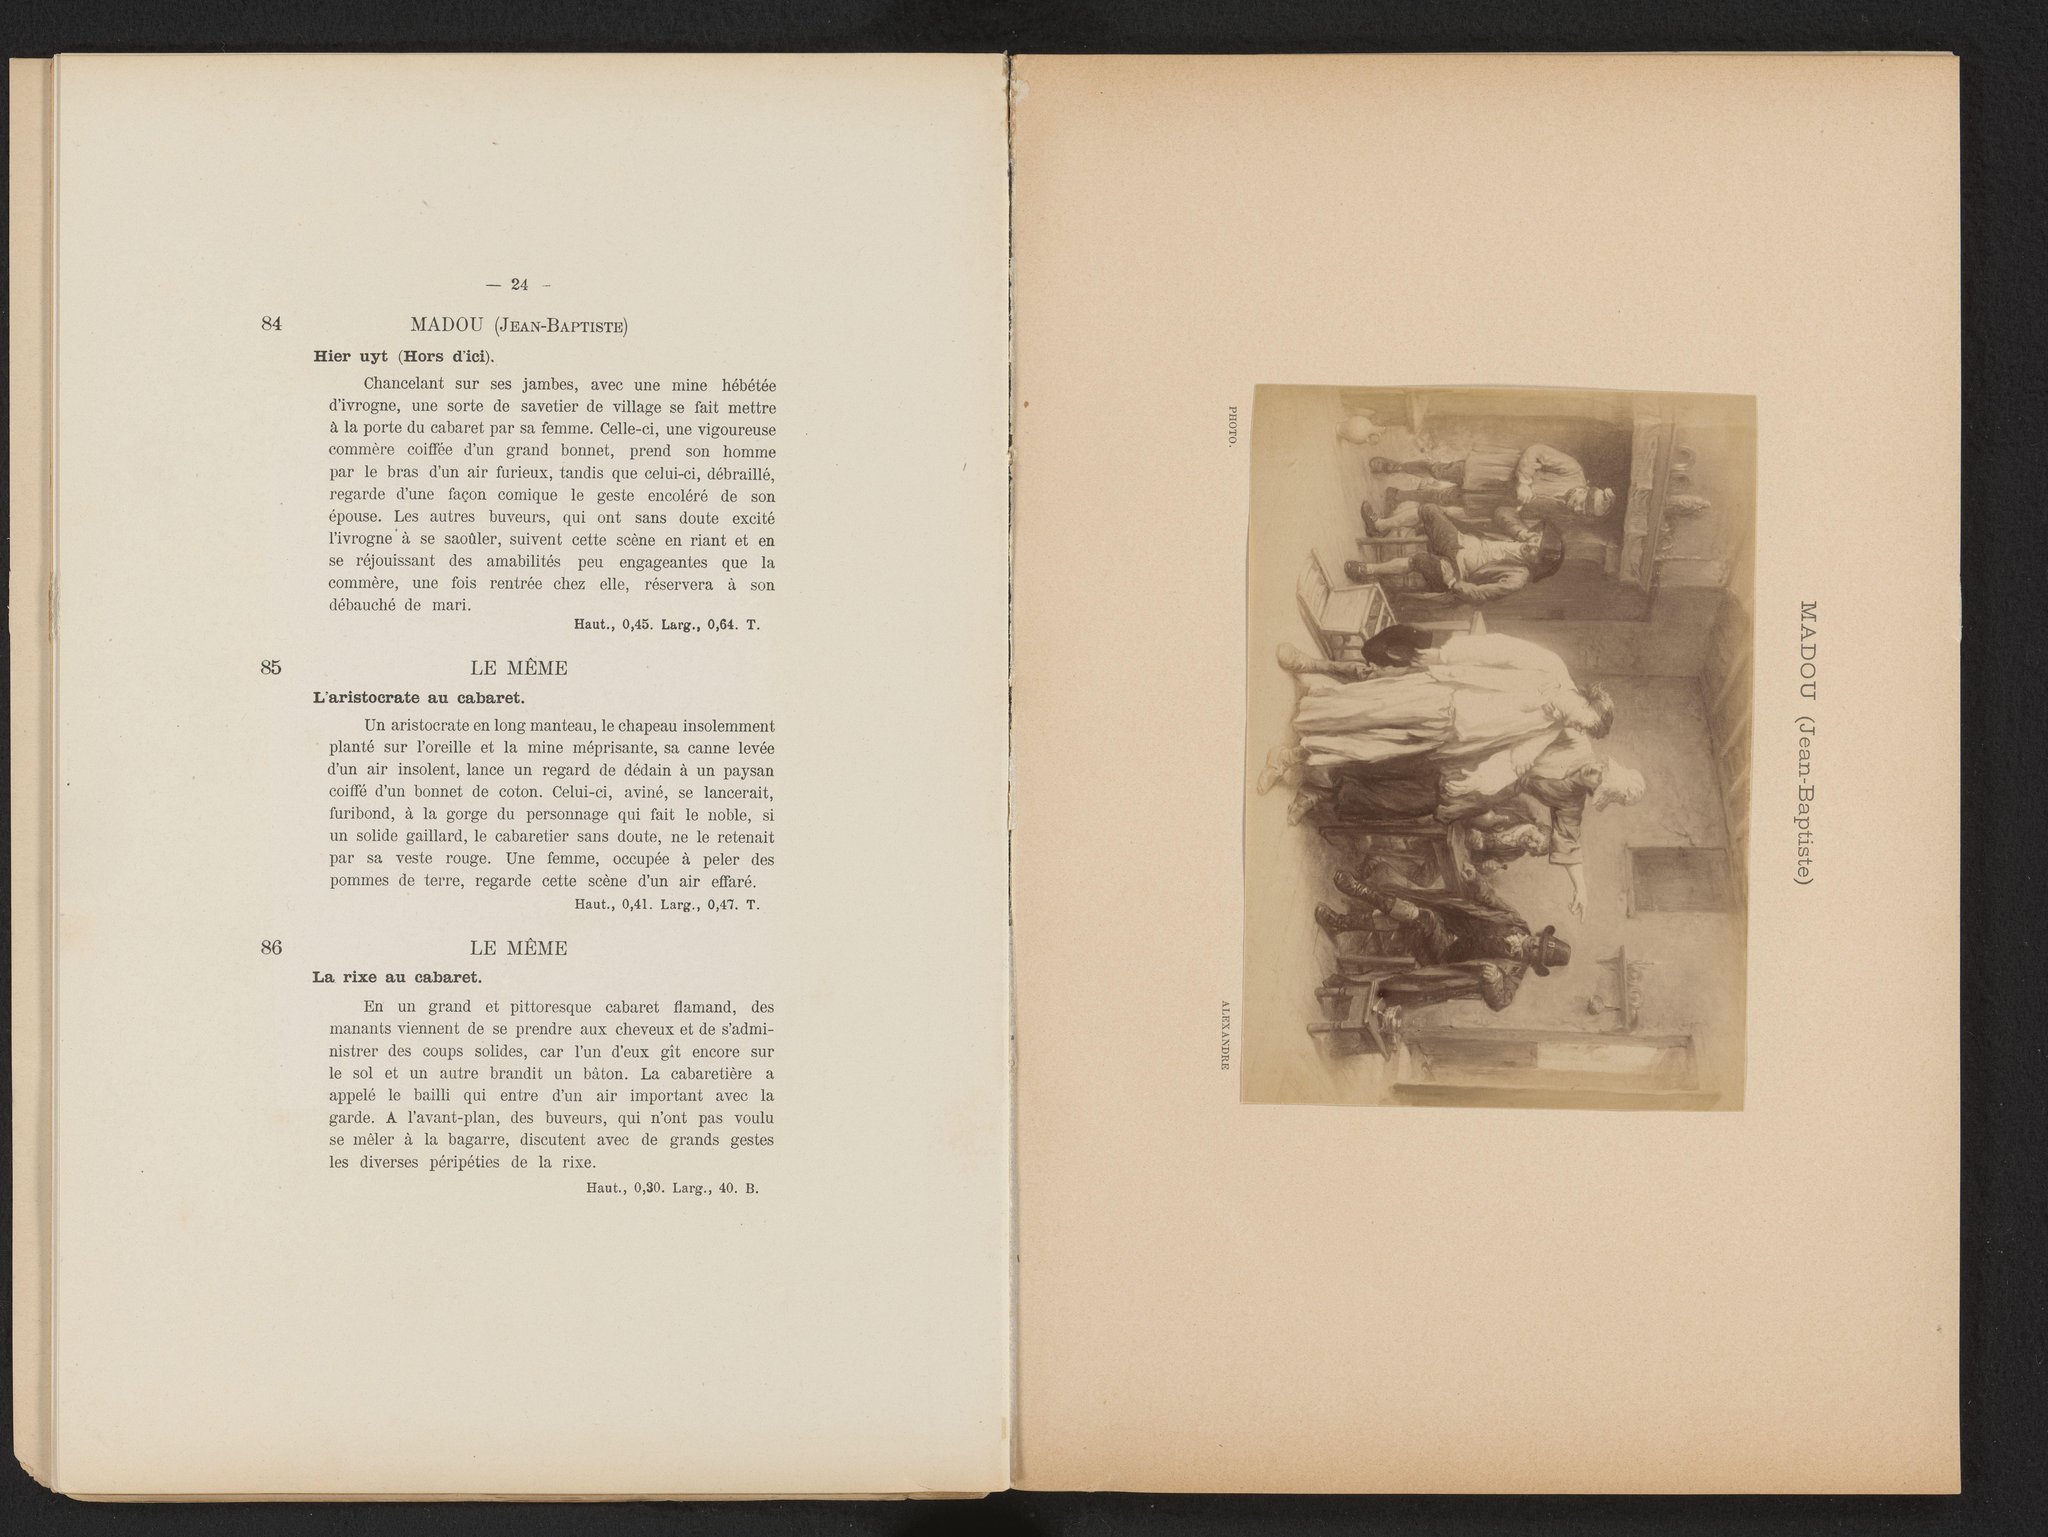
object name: reproduction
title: Madou (Jean-Baptiste)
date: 1888-1893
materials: photographic support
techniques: albumen print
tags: family life at home, painting, drawing and the graphic arts